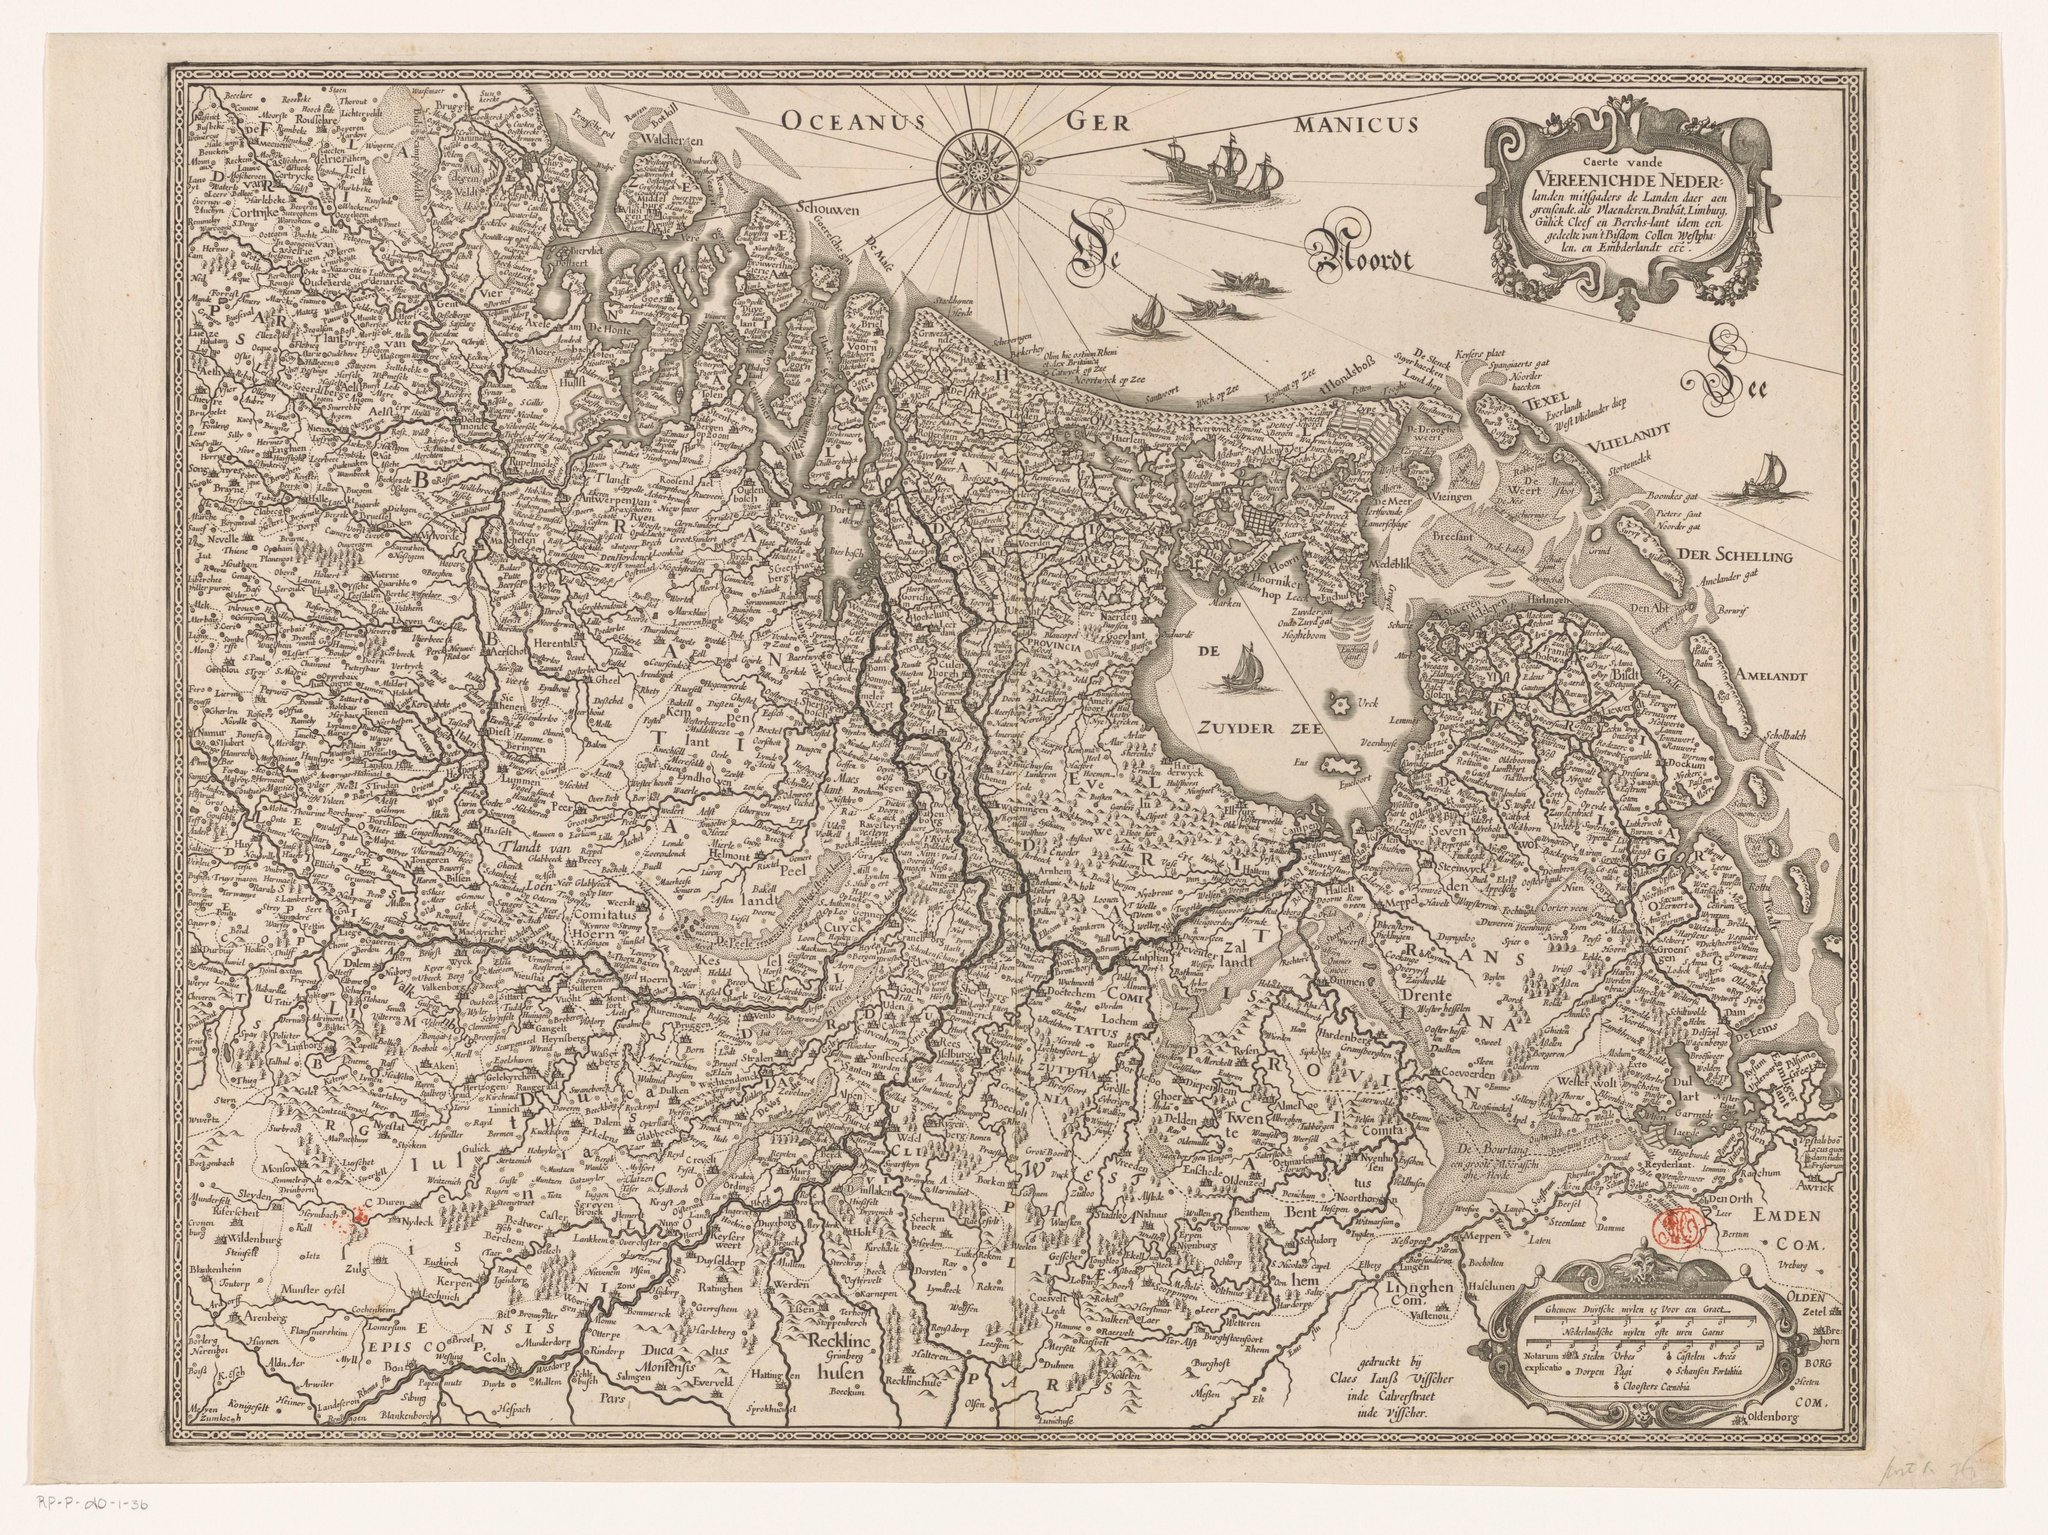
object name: print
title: Caerte vande Vereenichde Nederlanden (...)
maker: claes jansz. visscher (ii)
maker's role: draughtsman, print maker, publisher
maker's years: 1586-1652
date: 1621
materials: paper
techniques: engraving, etching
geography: amsterdam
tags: maps of separate countries or regions, netherlands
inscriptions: collector's mark: Lugt 2228, collector's mark: Lugt 195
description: Rechtsboven cartouche met titel. Rechtsonder cartouche met legenda en schaalstok: Ghemene Duytsche mijlen 15 voor een graet, Nederlandsche mijlen ofte uren gaens. Oriëntatie: noorden rechts.